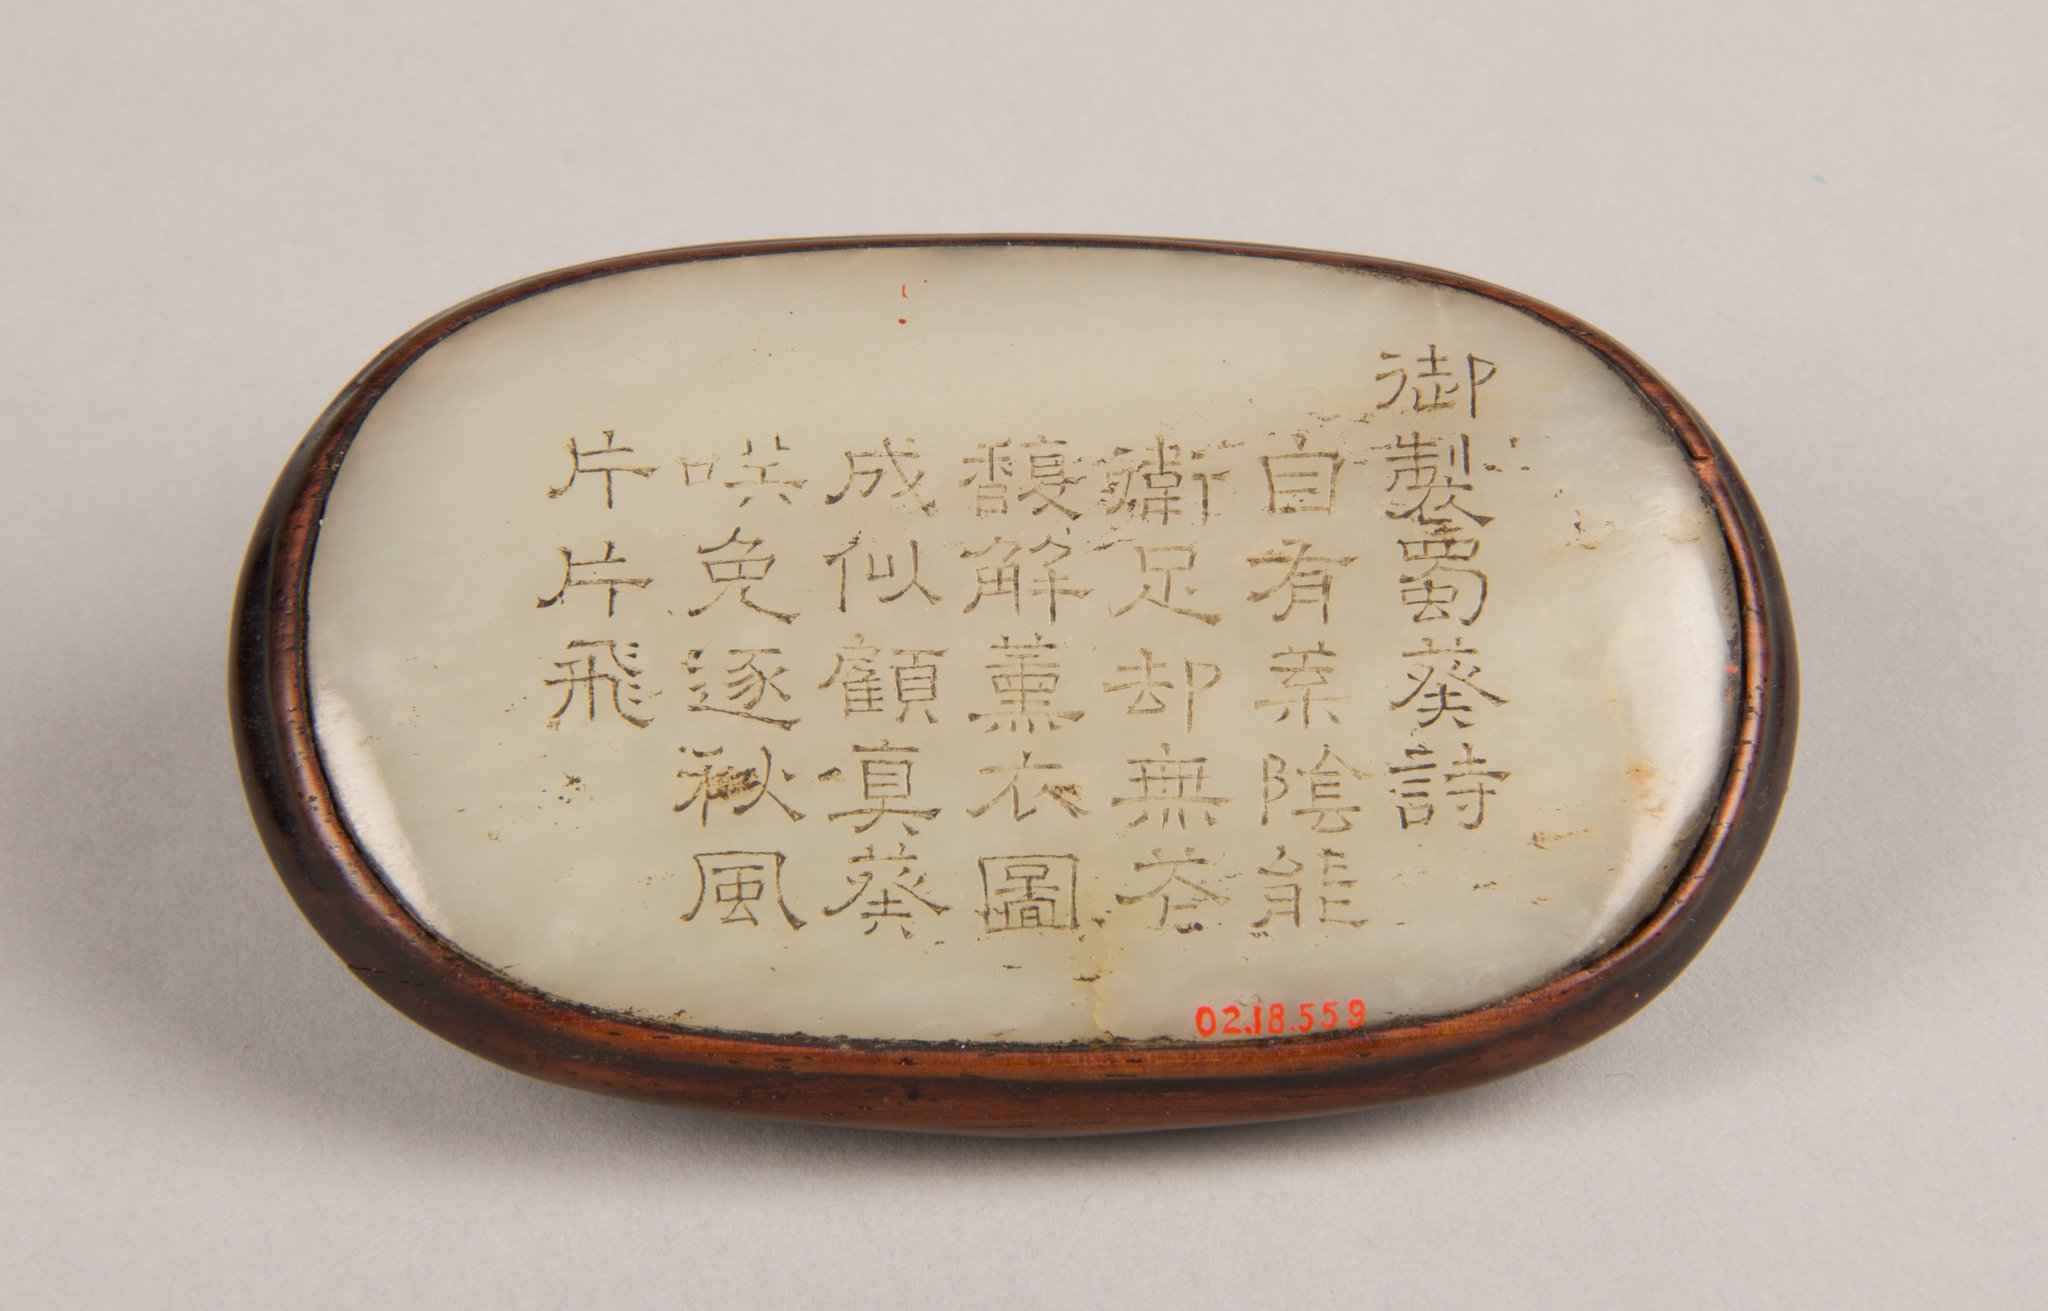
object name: girdle plaque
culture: chinese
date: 1736-1795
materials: jade